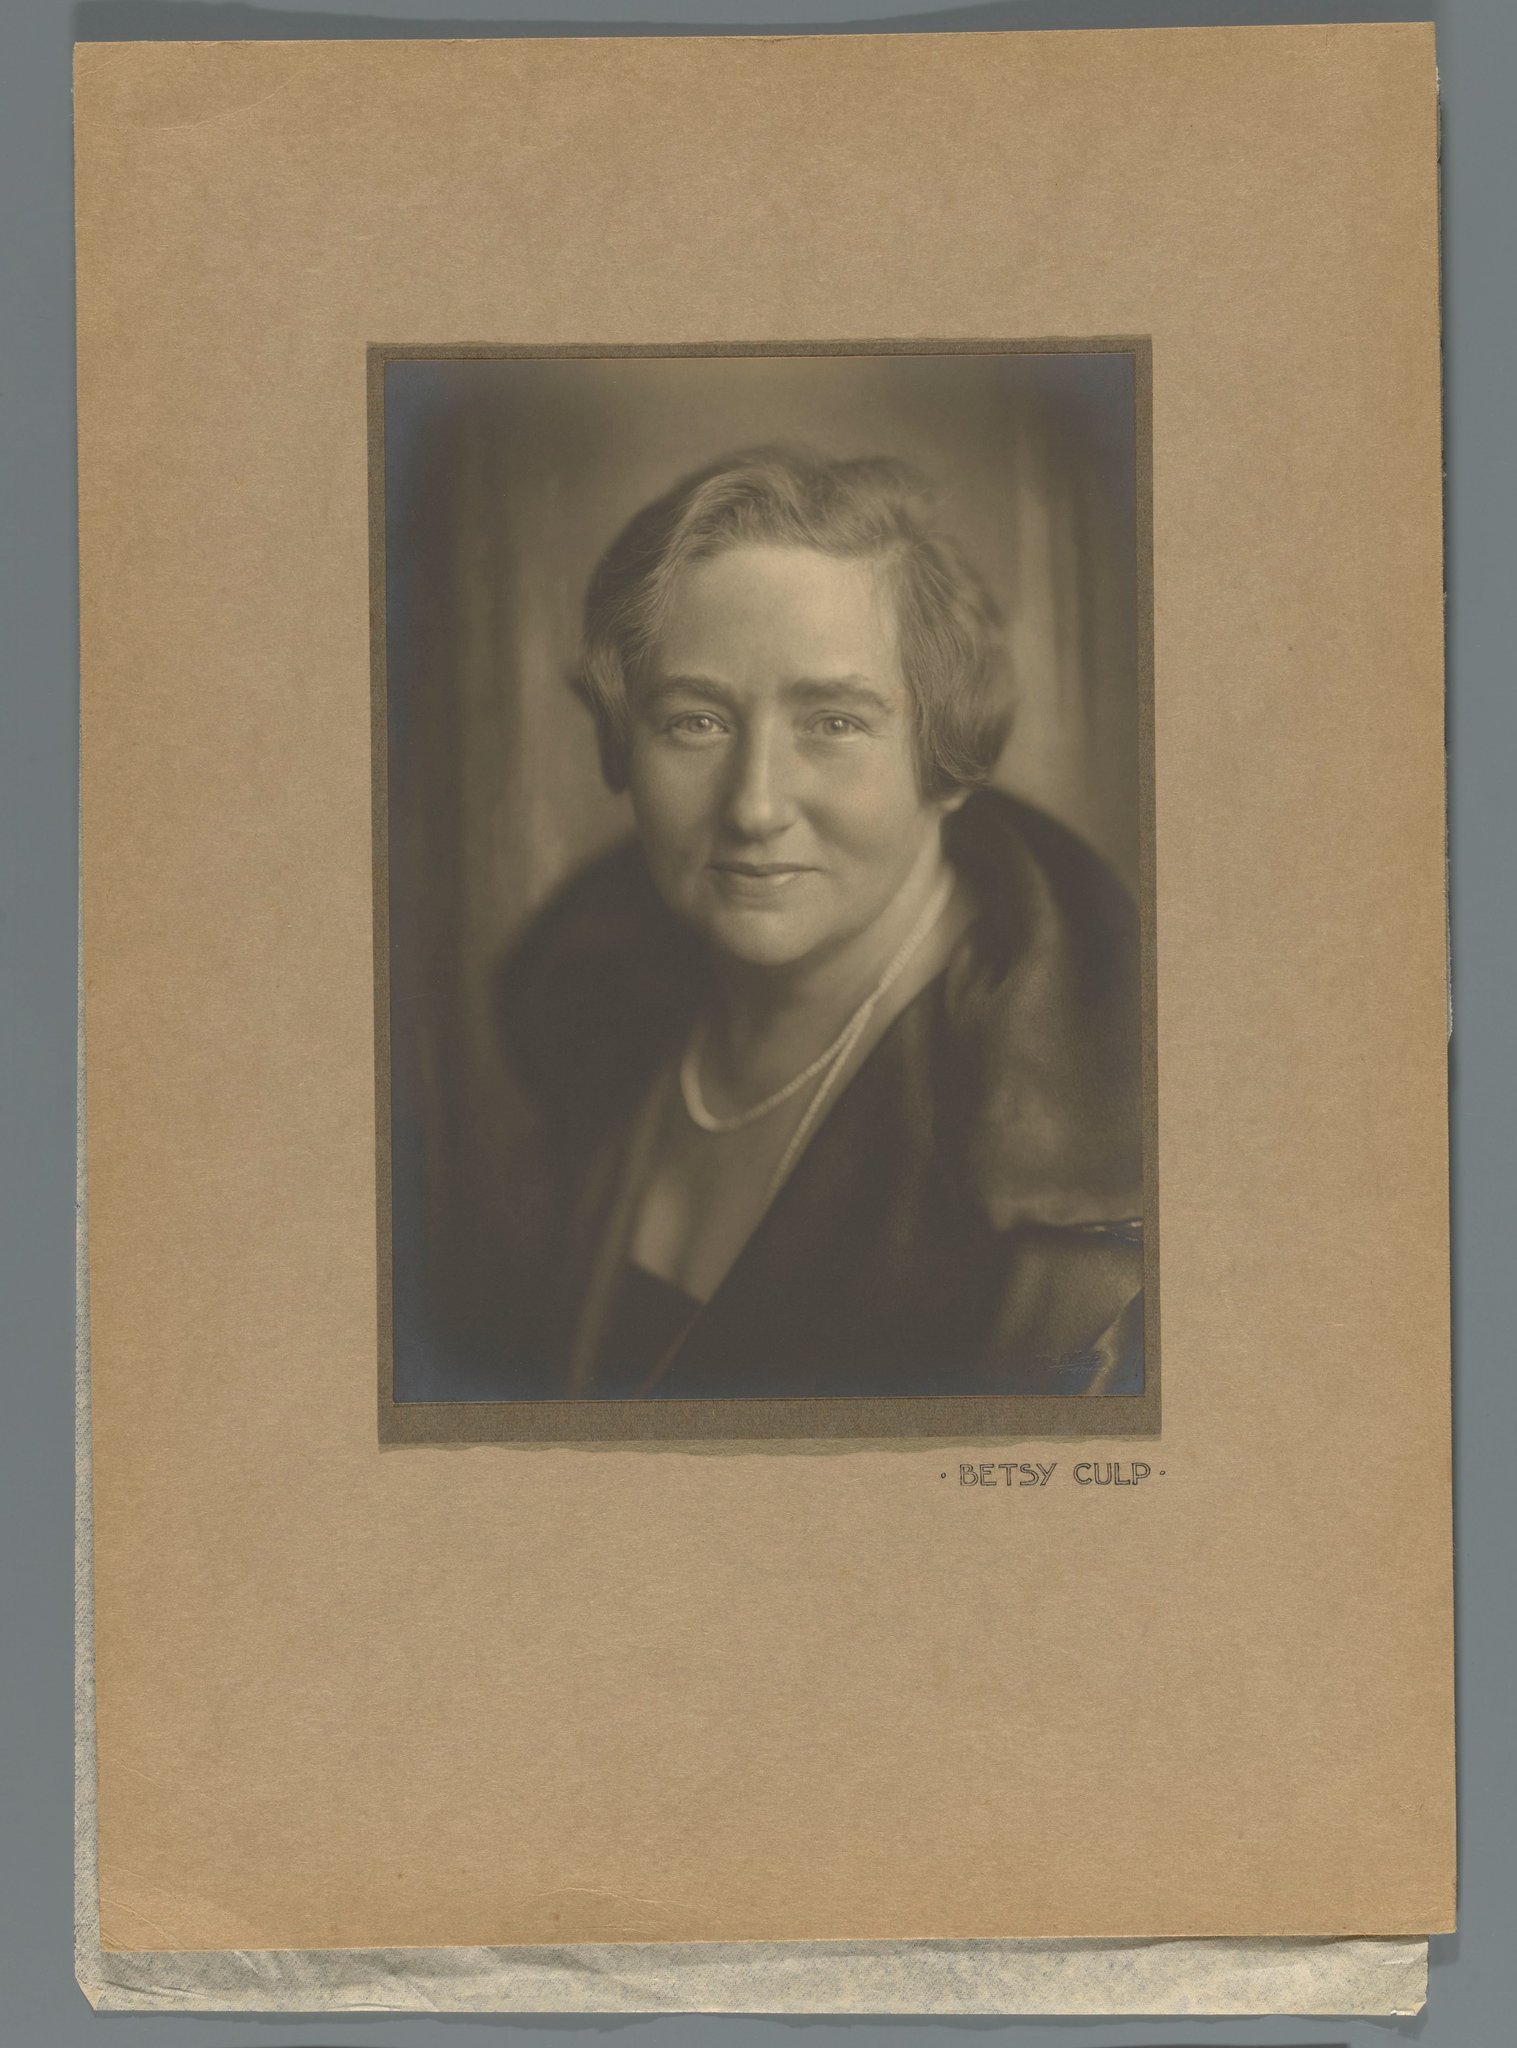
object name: photograph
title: Portret van Betsy Culp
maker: jacob merkelbach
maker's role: fotograaf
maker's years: 1877-1942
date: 1925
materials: cardboard, paper, photographic support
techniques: gelatin silver print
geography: amsterdam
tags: historical persons (portraits and scenes from the life) - bb - woman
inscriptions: annotation: ‘Photographs for exhibition only, no commercial value, to be returned.’, inscription: ‘Betsy Culp’, annotation: ‘Accepted and hung at The International Exhibition of Pictoral Photography...’